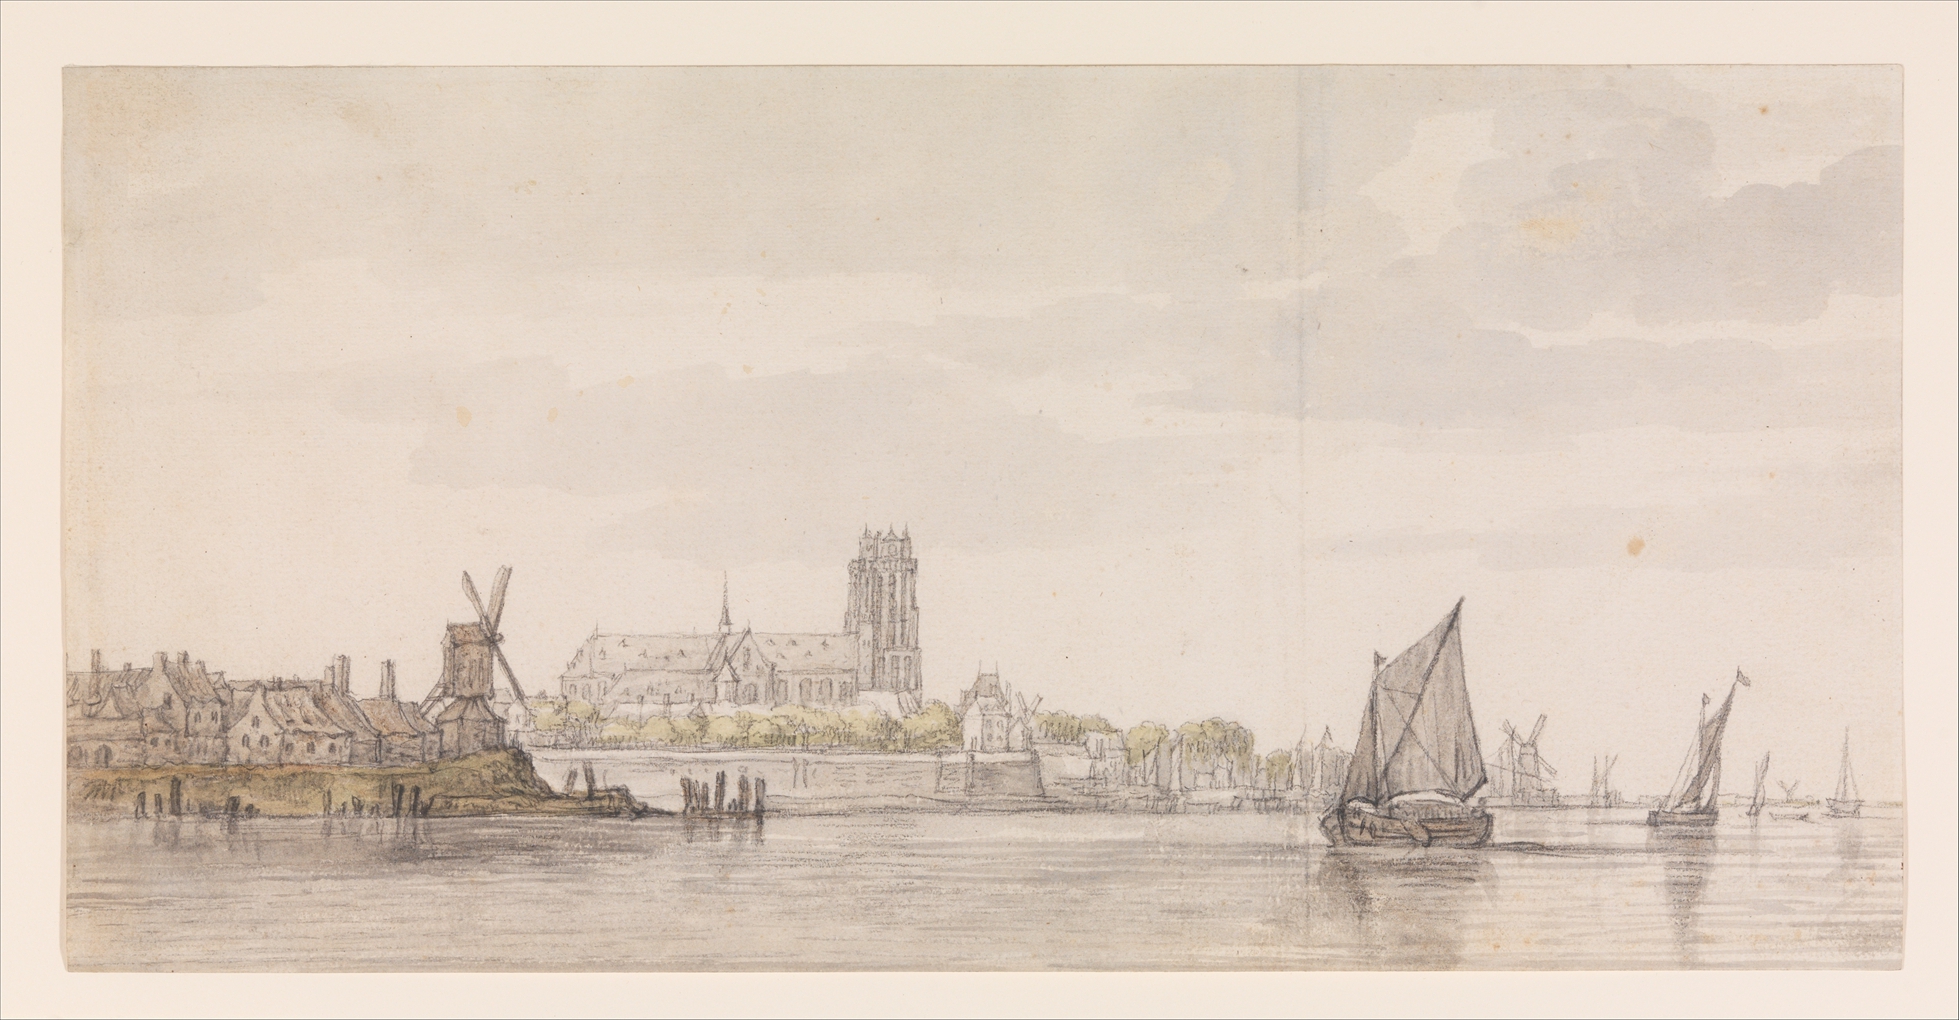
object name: drawing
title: View of the Groote Kerk in Dordrecht from the River Maas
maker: aelbert cuyp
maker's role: artist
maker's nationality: dutch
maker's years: 1620-1691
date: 1647-1648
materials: chalk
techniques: wash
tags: windmills,churches,rivers,boats